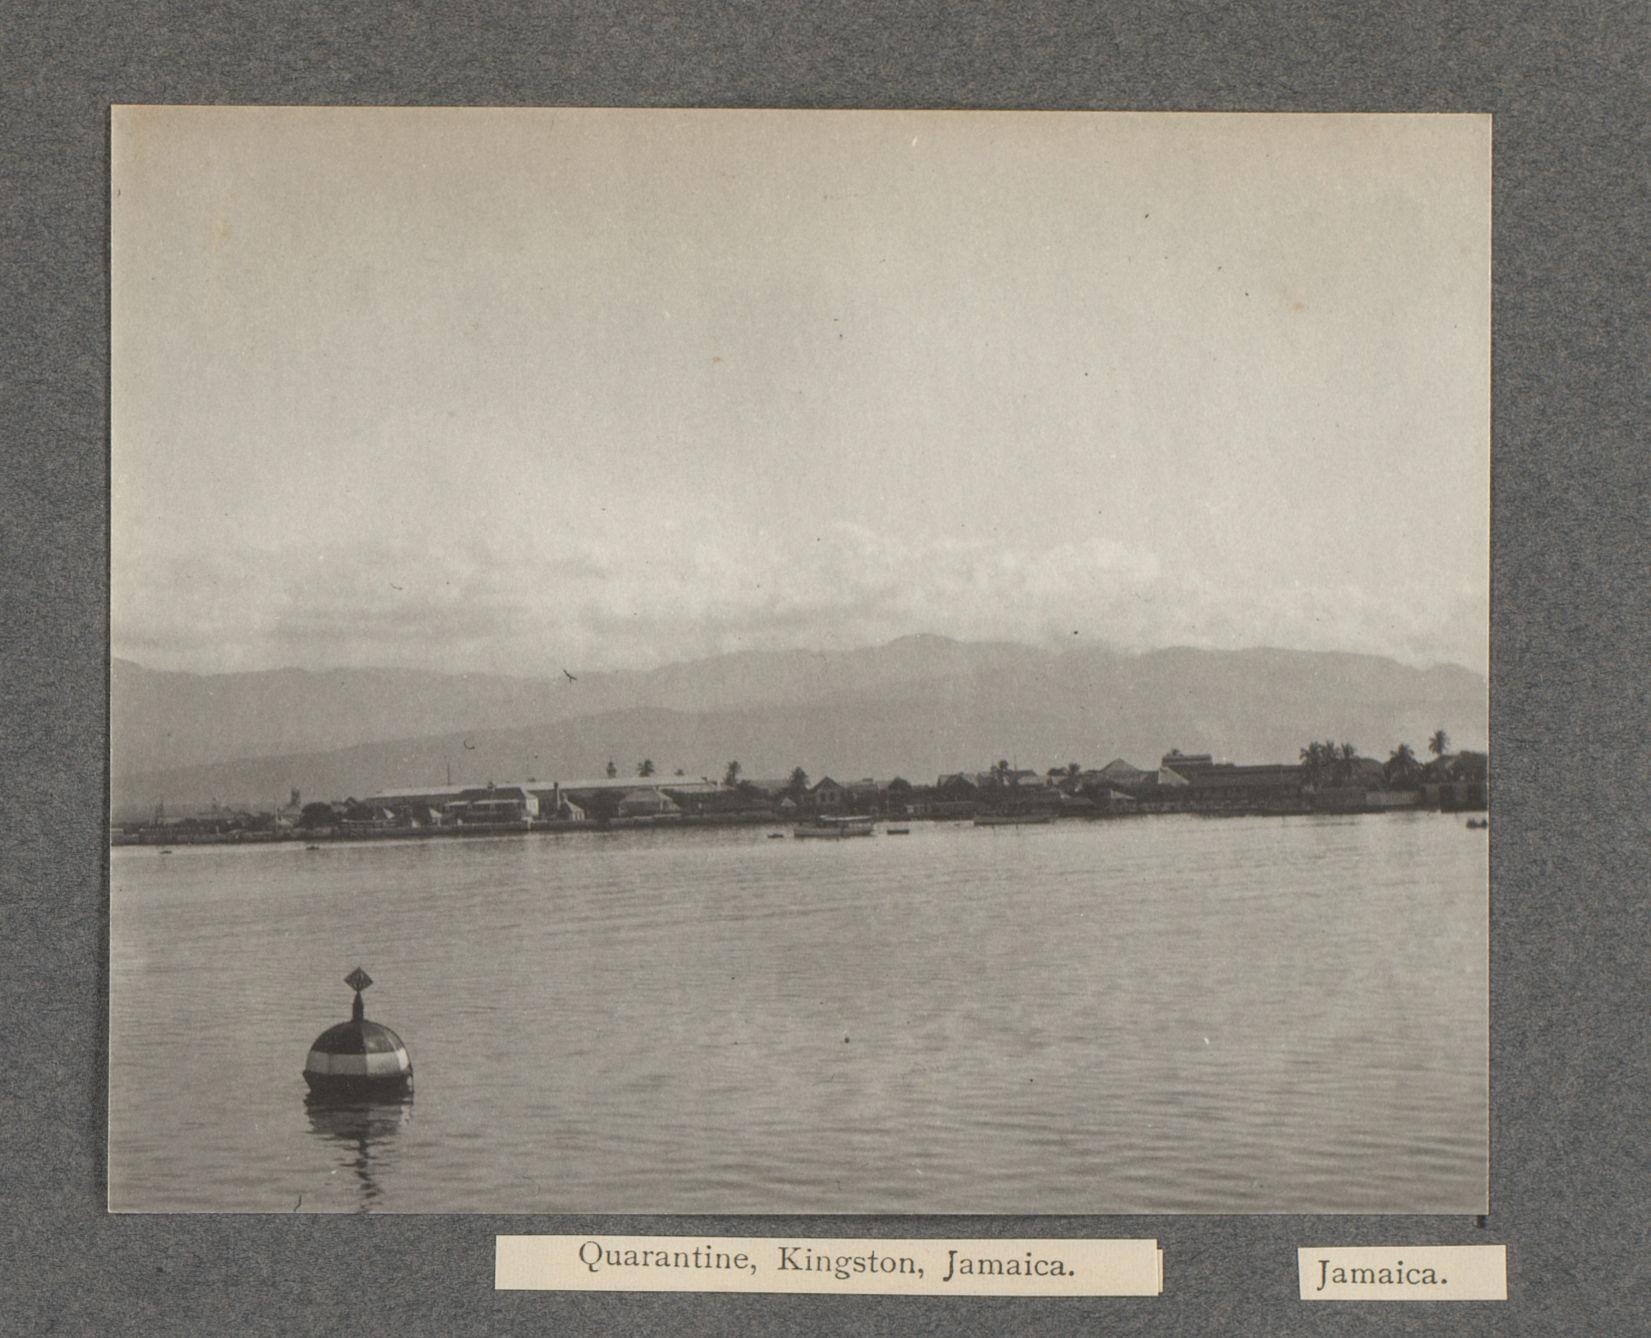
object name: photograph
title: Quarantine, Kingston, Jamaica. Jamaica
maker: Anonymous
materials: paper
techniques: platinum process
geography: kingston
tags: gulf, bay, prospect of village, silhouette of village